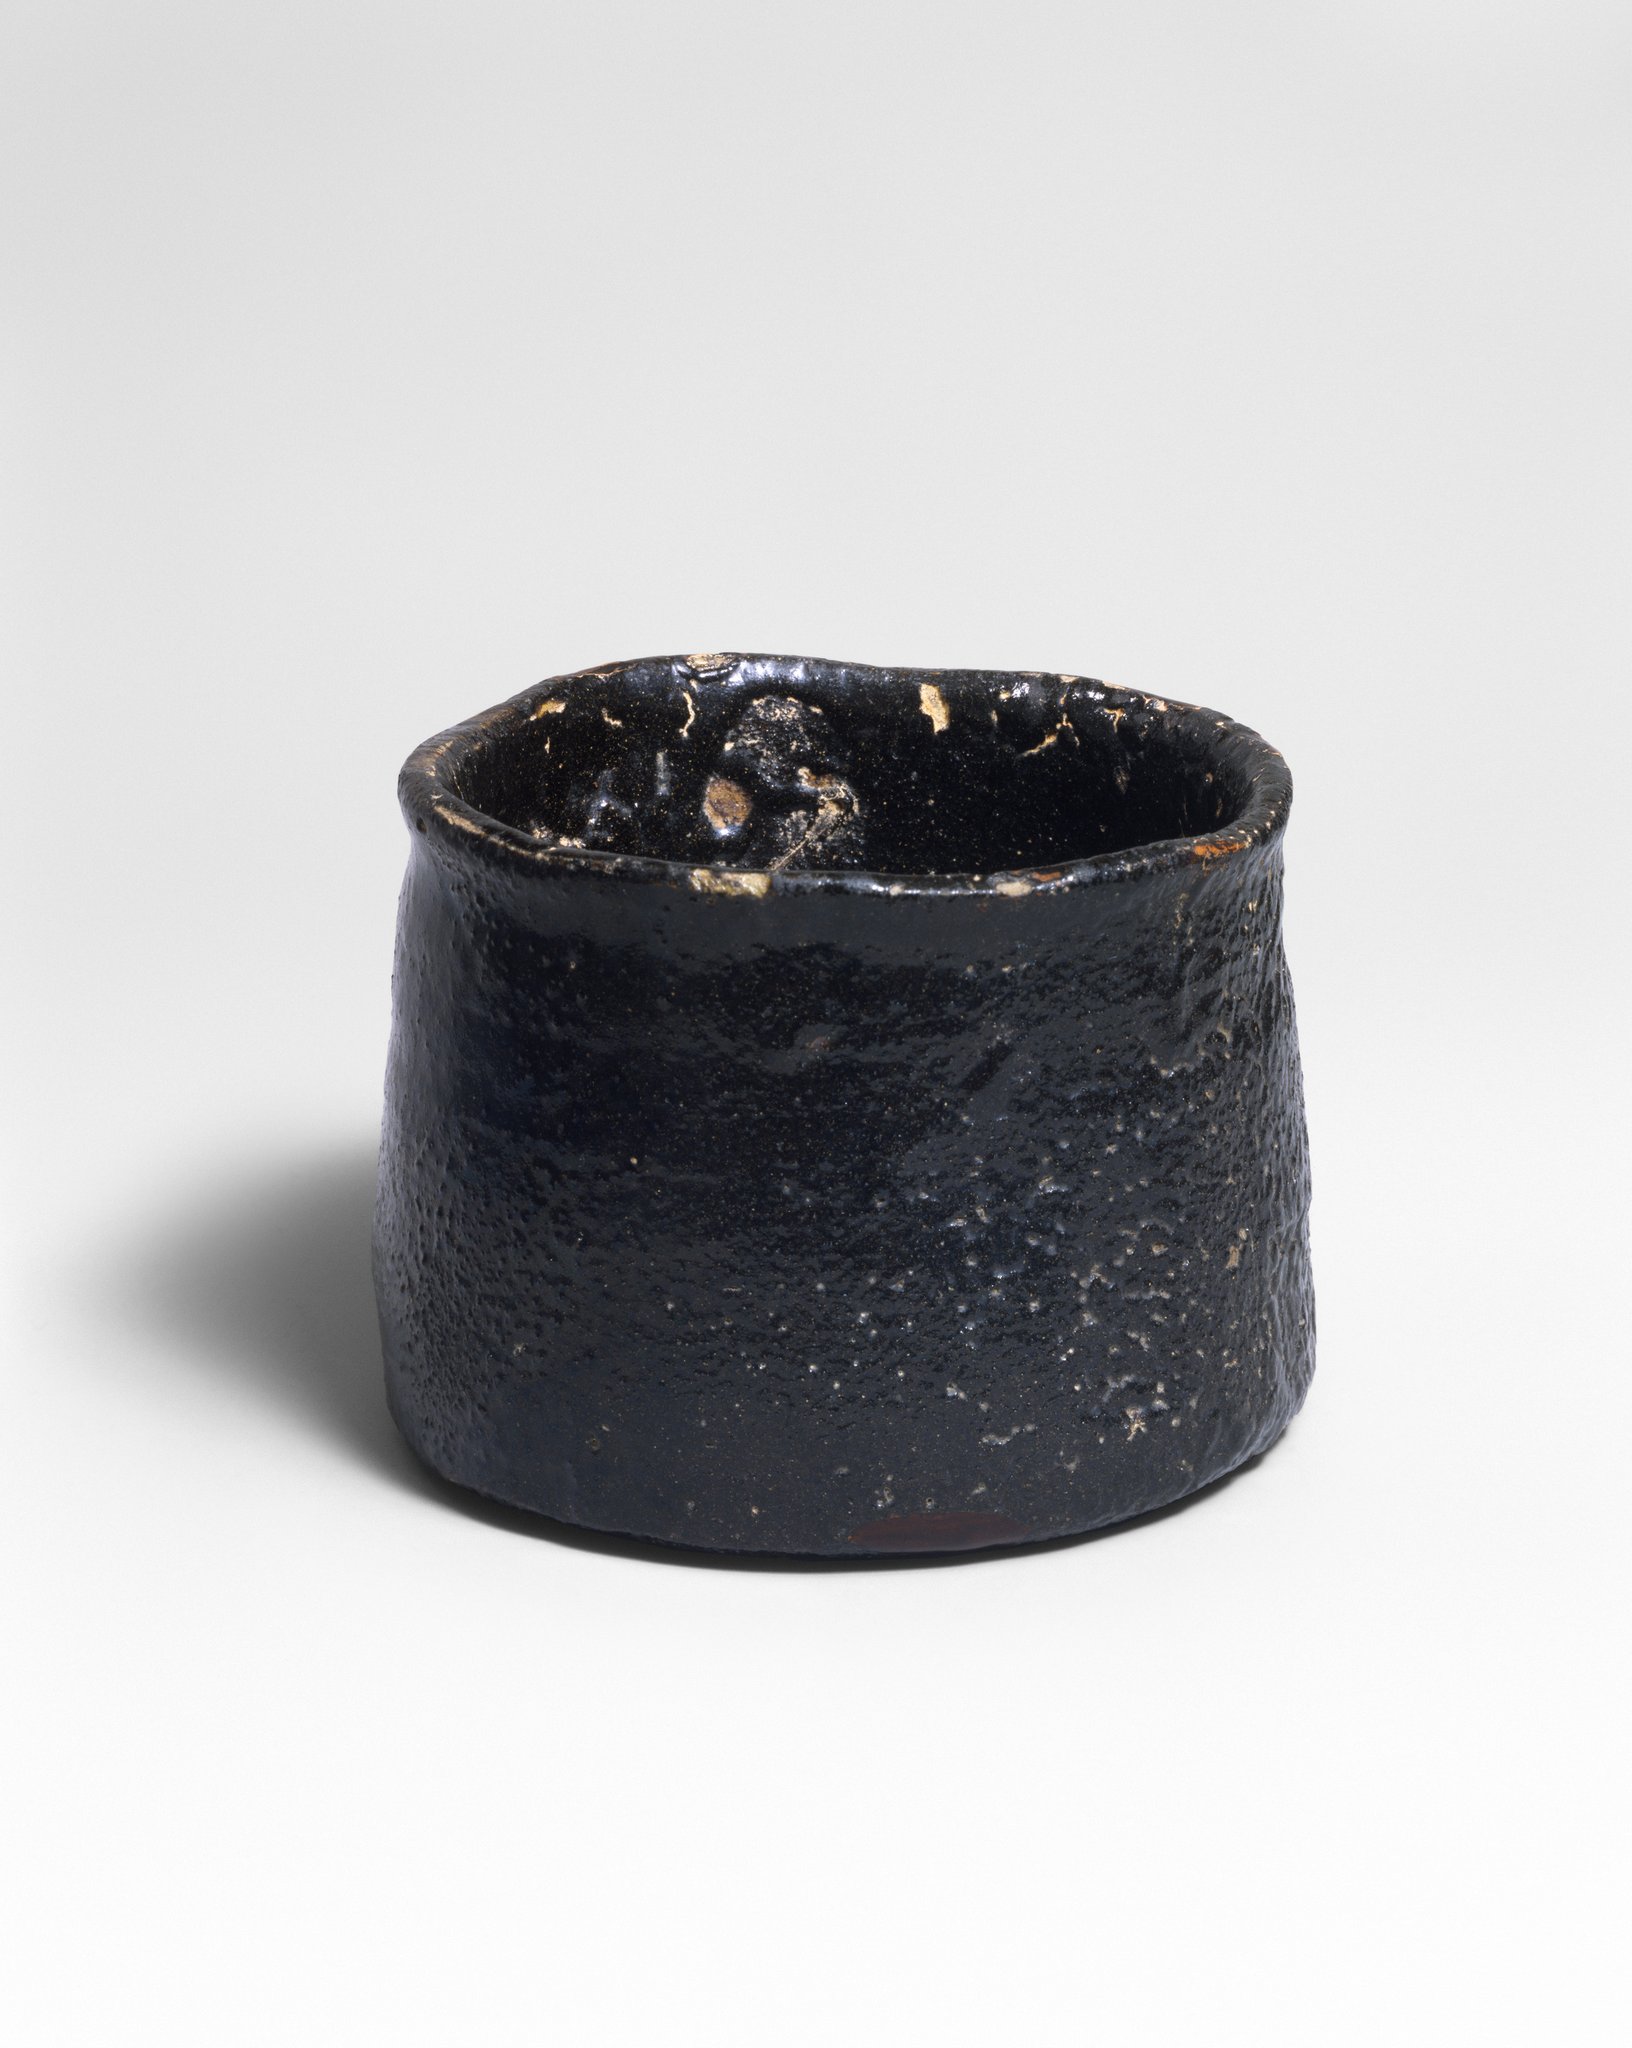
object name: teabowl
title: Black Seto (Seto-guro) Tea Bowl, named Iron Mallet (Tettsui)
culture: japanese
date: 1567-1600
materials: glaze, stoneware